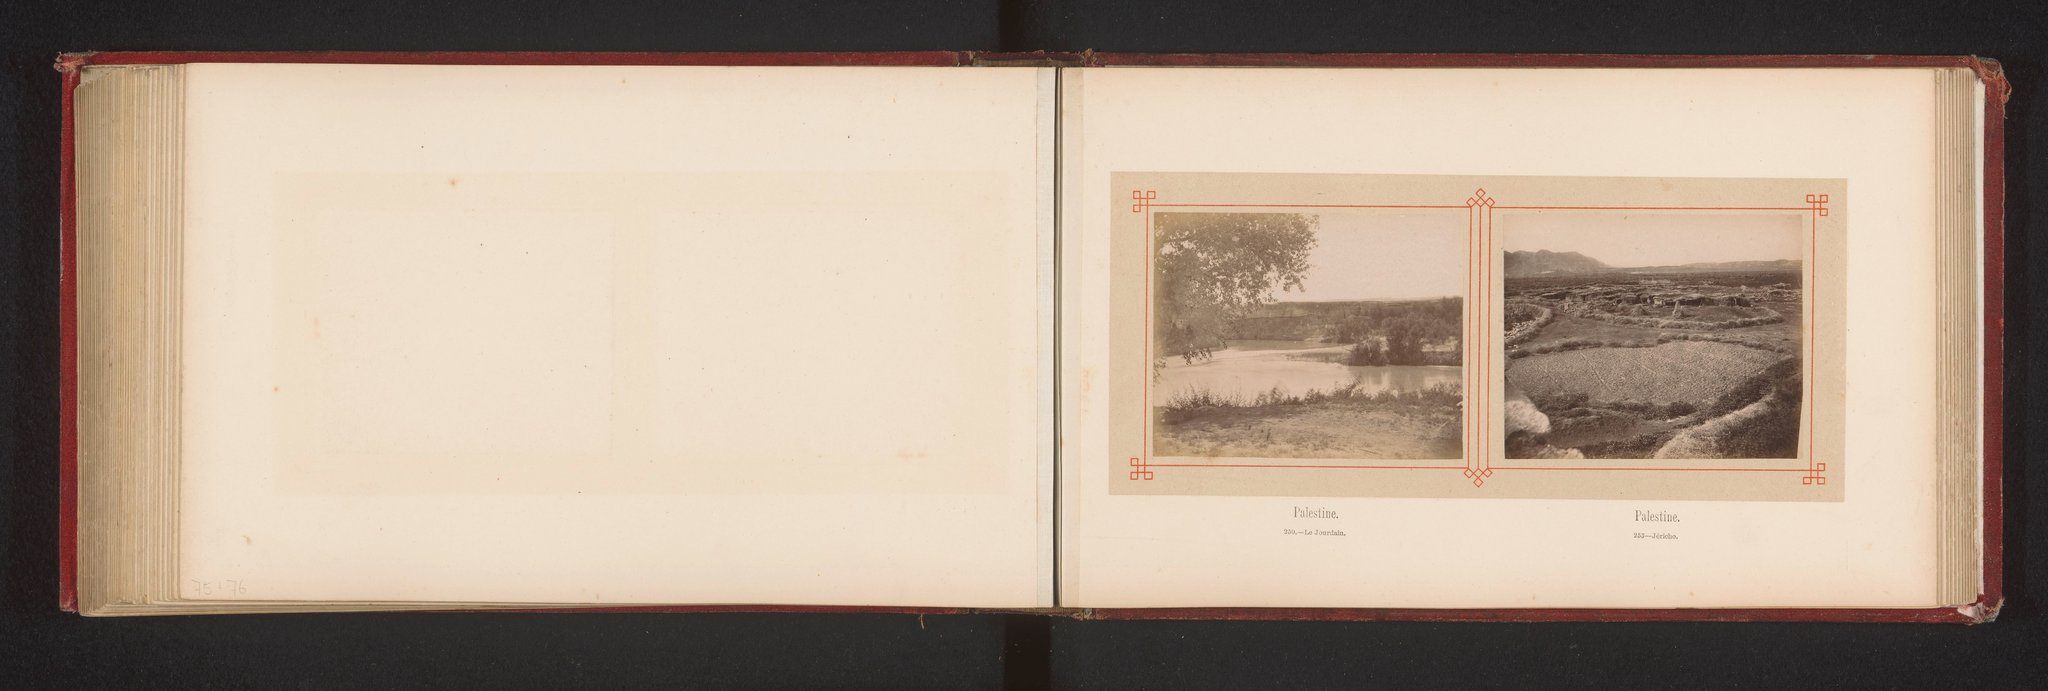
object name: photograph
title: Gezicht op een landschap met water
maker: félix bonfils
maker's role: fotograaf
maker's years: 1831-1885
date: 1873-1878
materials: photographic support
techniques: albumen print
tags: landscapes with waters, waterscapes, seascapes (in the temperate zone)